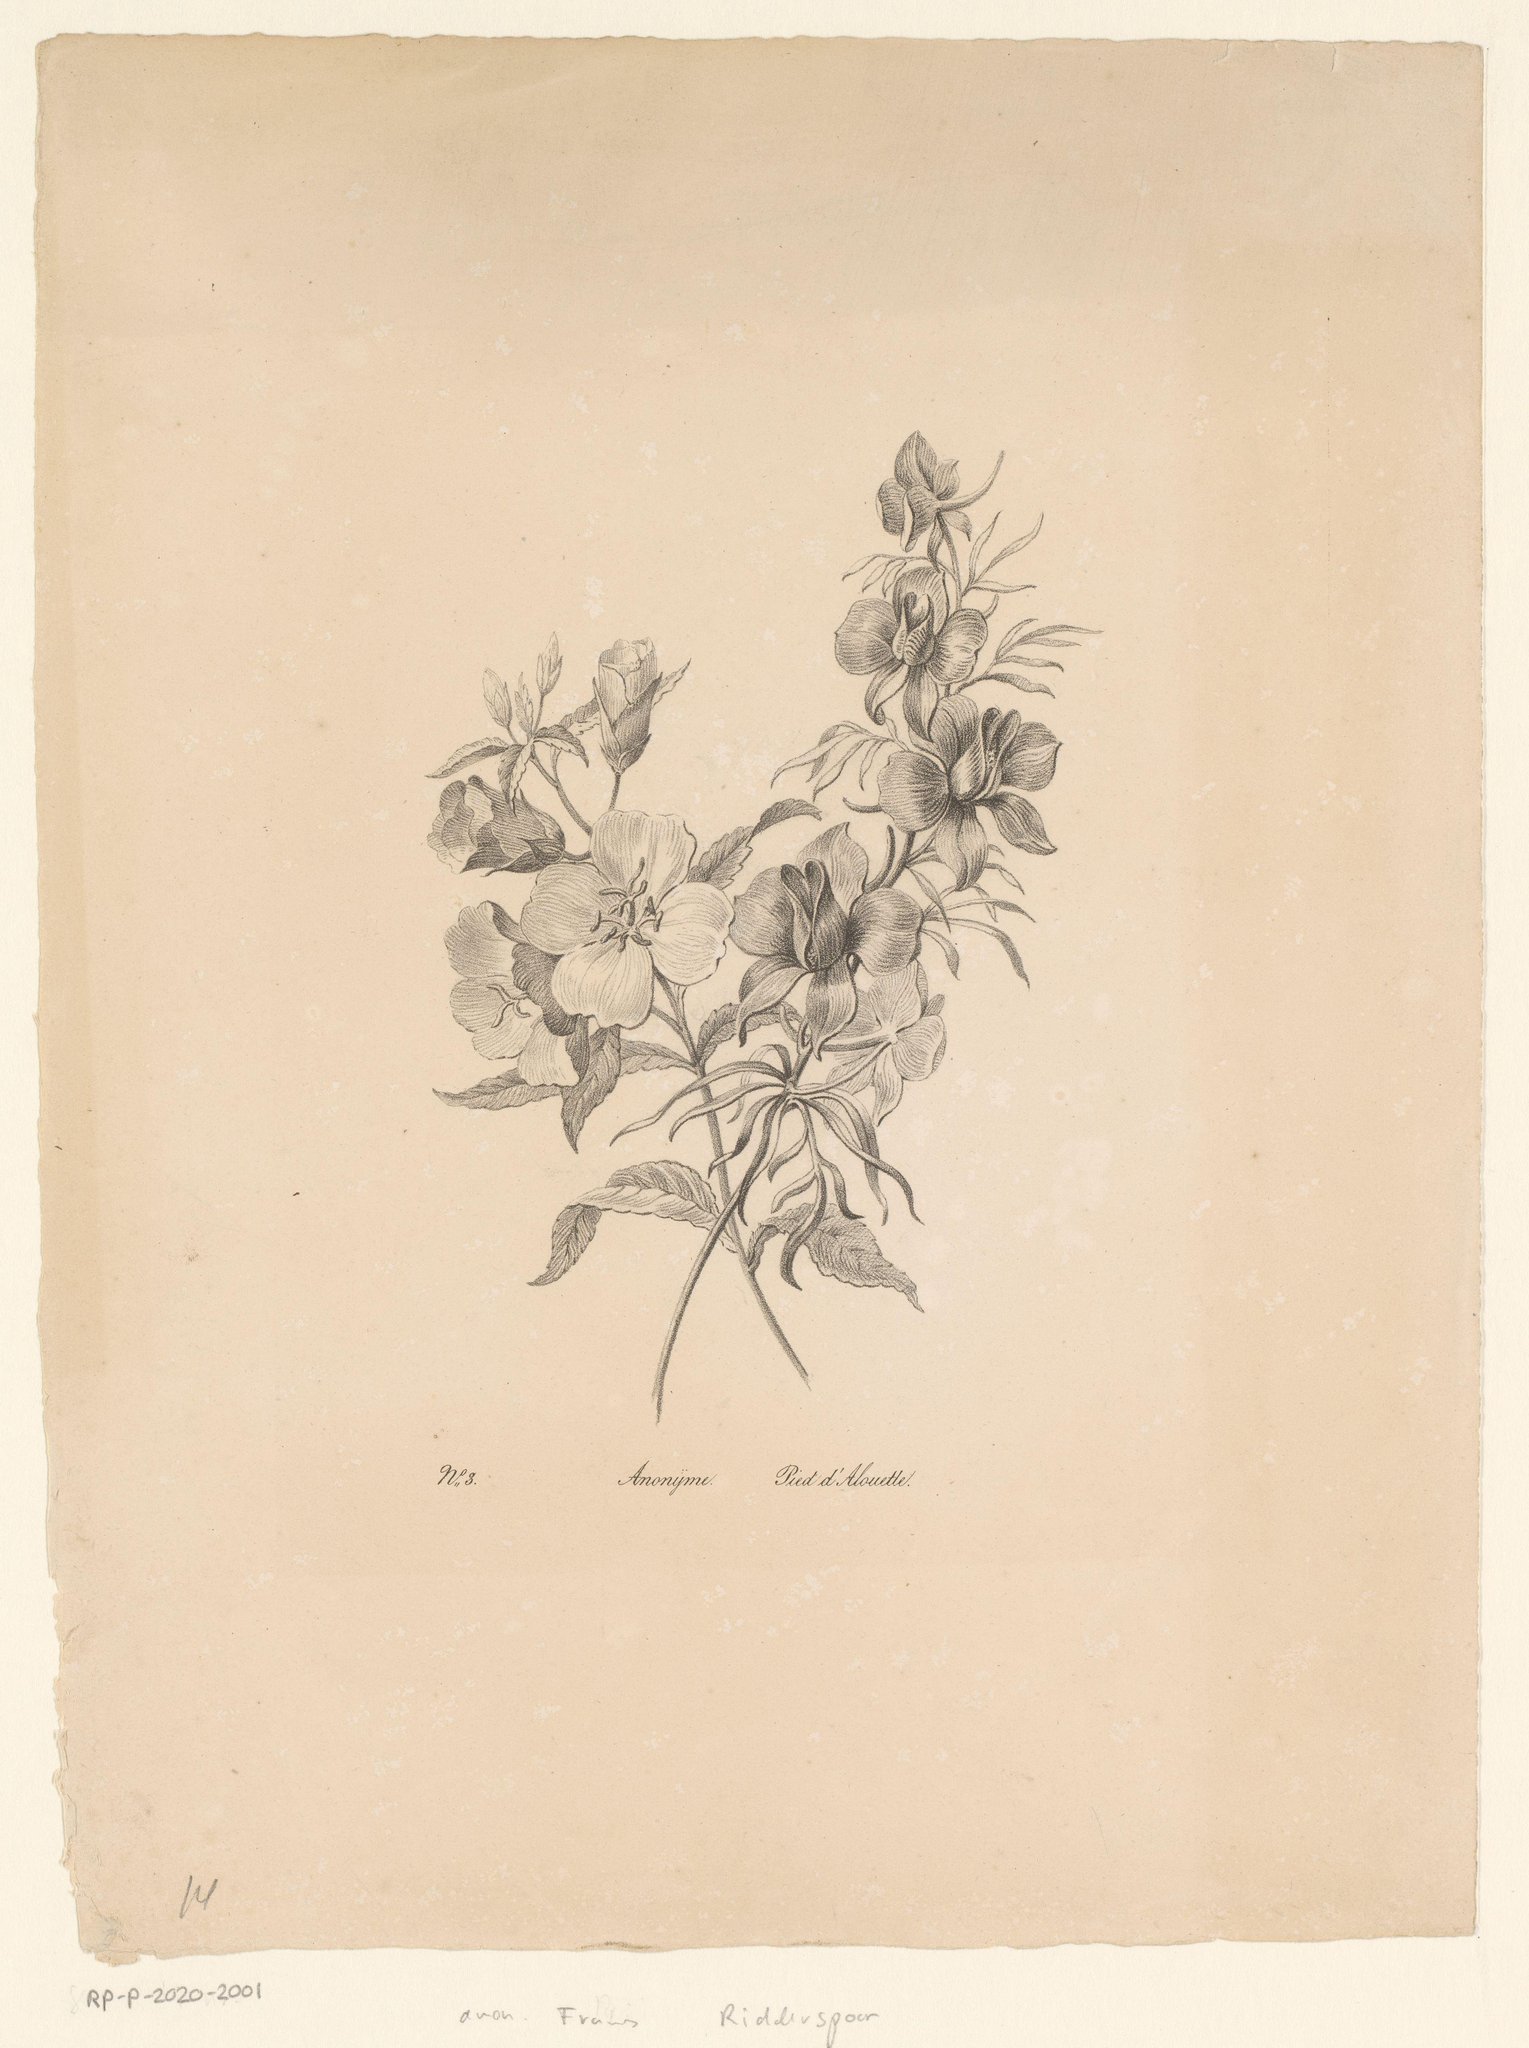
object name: print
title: Ridderspoor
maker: Anonymous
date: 1800-1850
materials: paper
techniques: lithograph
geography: france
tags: flowers: delphinium